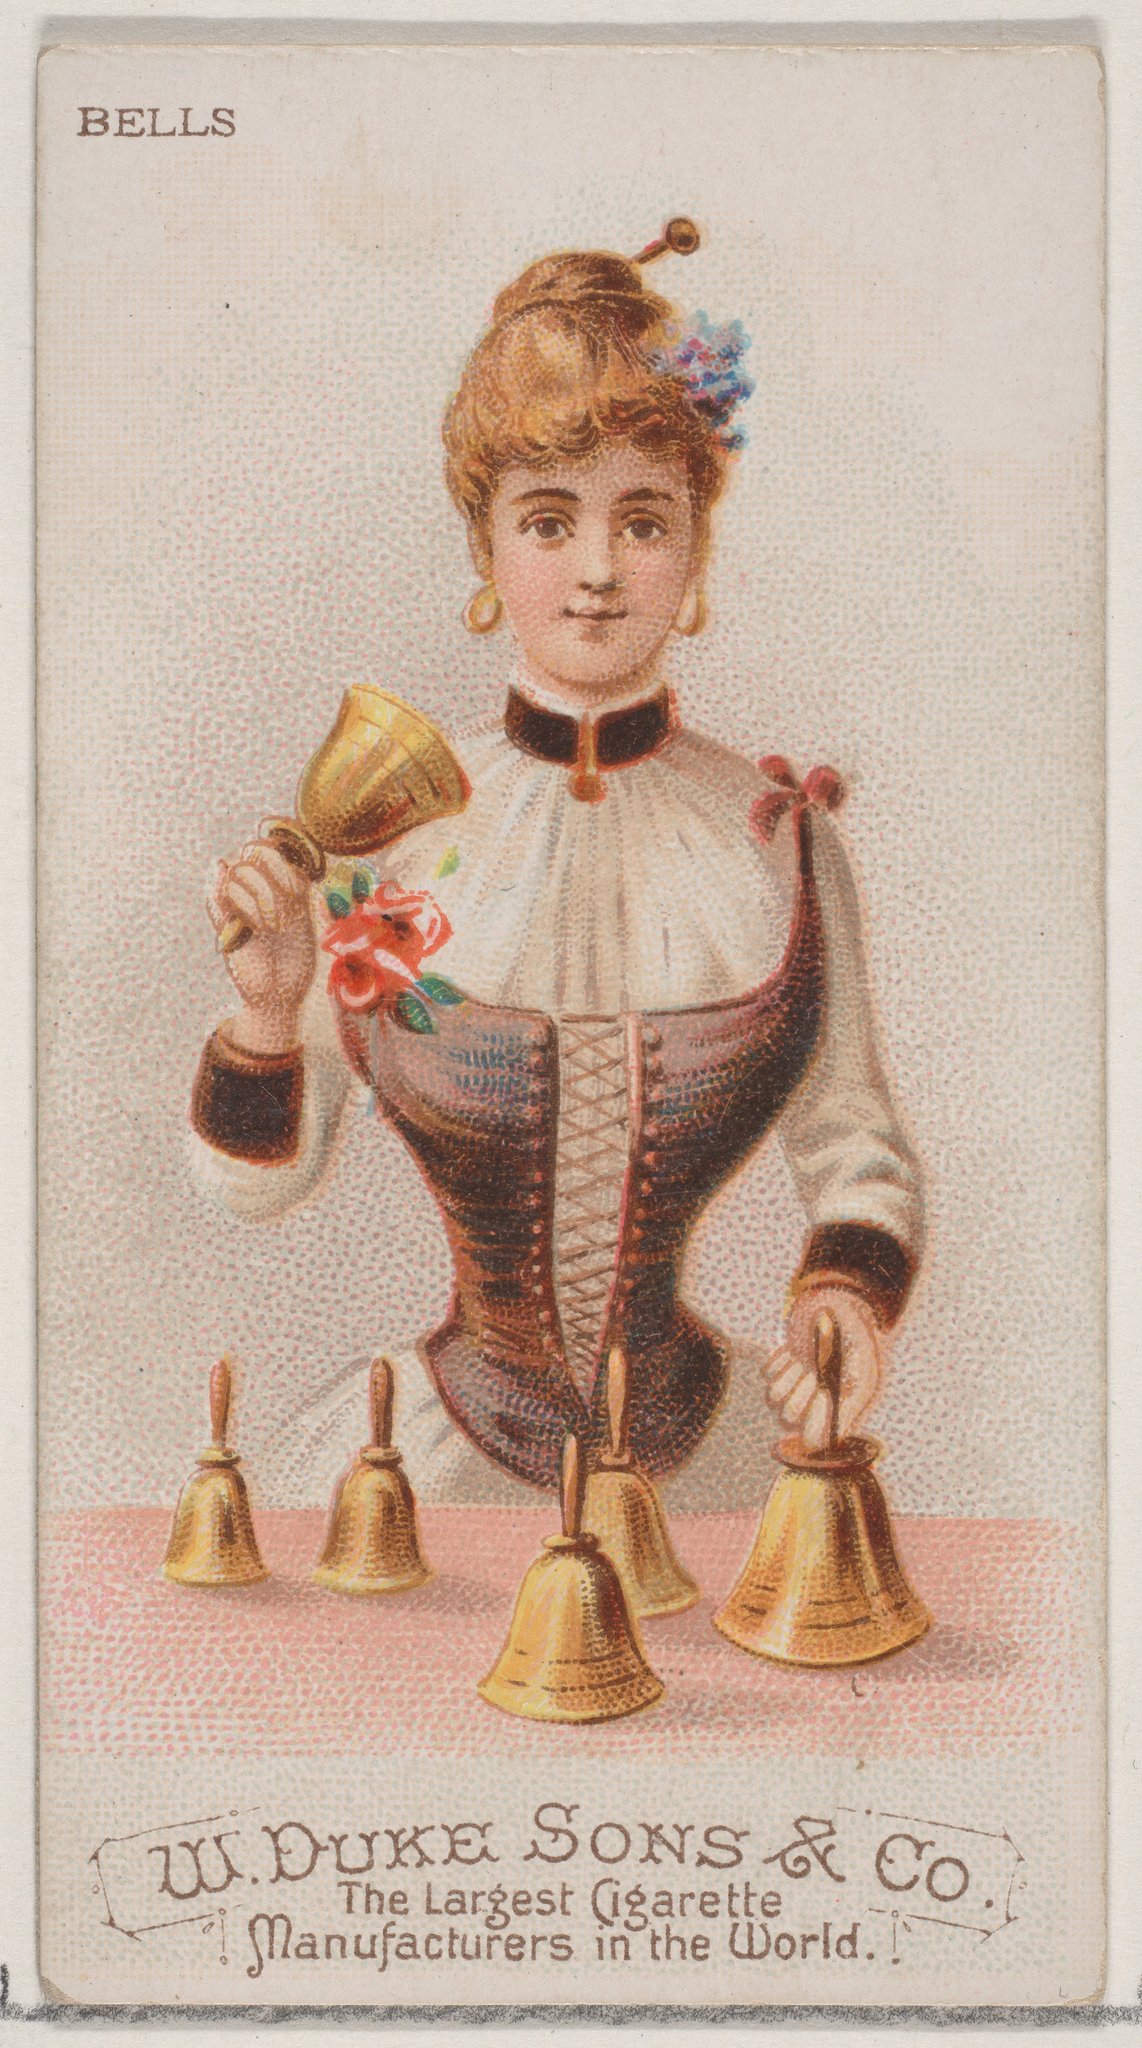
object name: print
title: Bells, from the Musical Instruments series (N82) for Duke brand cigarettes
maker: w. duke, sons & co.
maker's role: publisher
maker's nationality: american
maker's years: 1870-1920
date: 1888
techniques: color lithograph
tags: women,musicians,bells